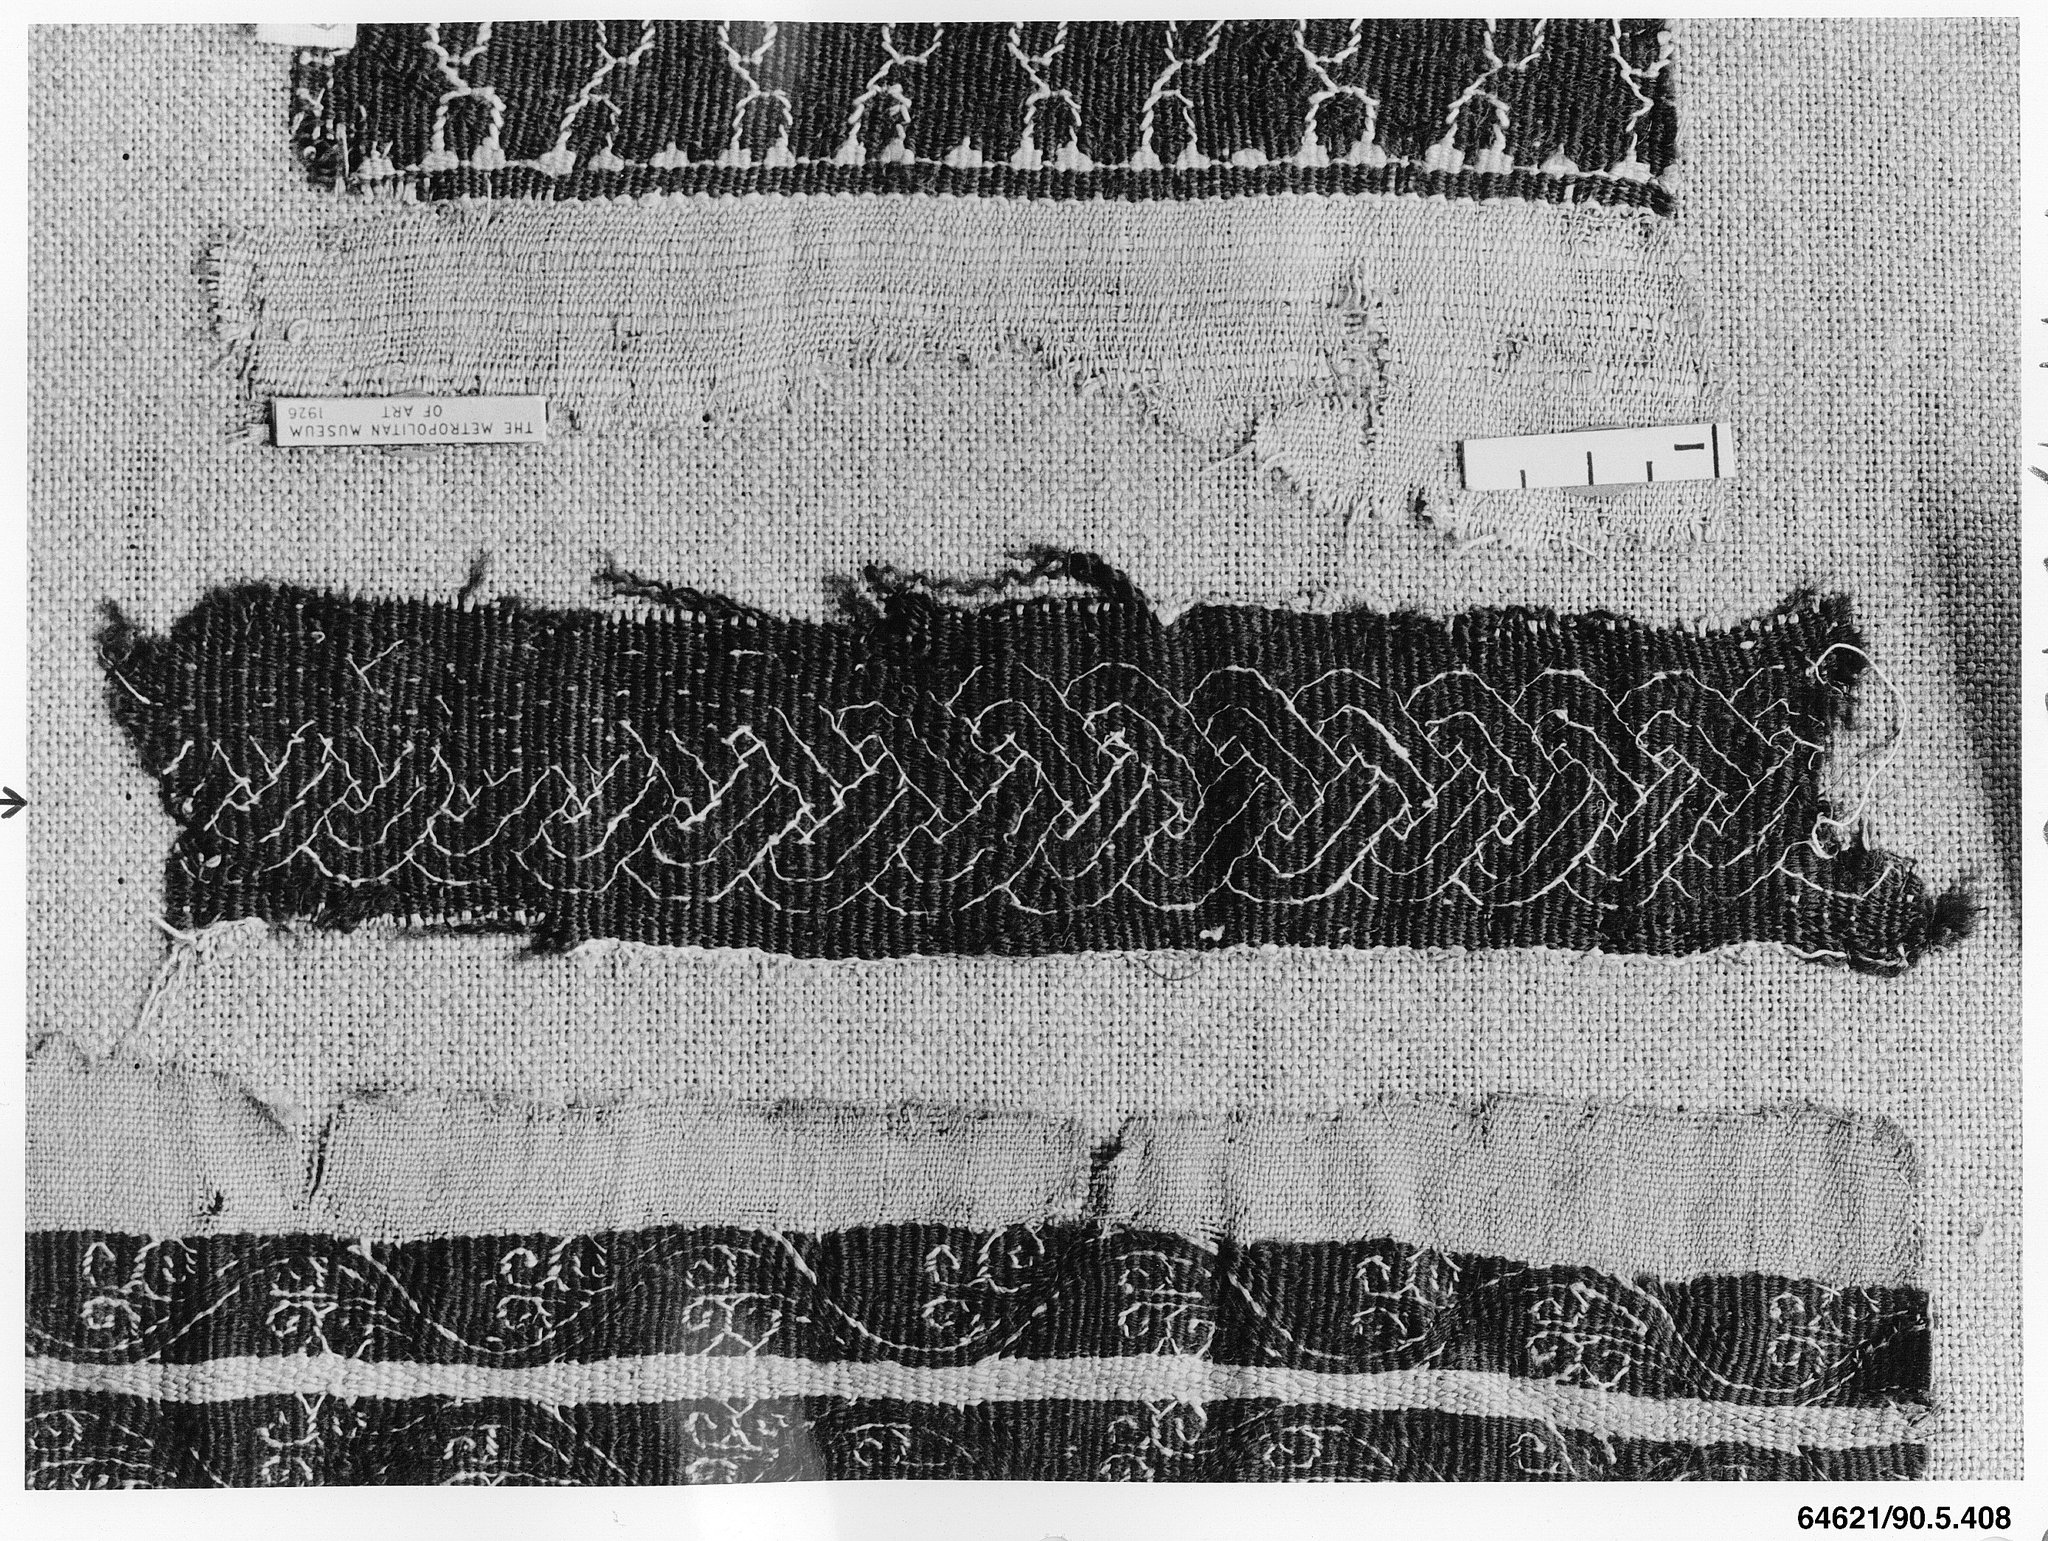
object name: textile fragment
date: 201-400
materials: linen, wool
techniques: weave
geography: egypt